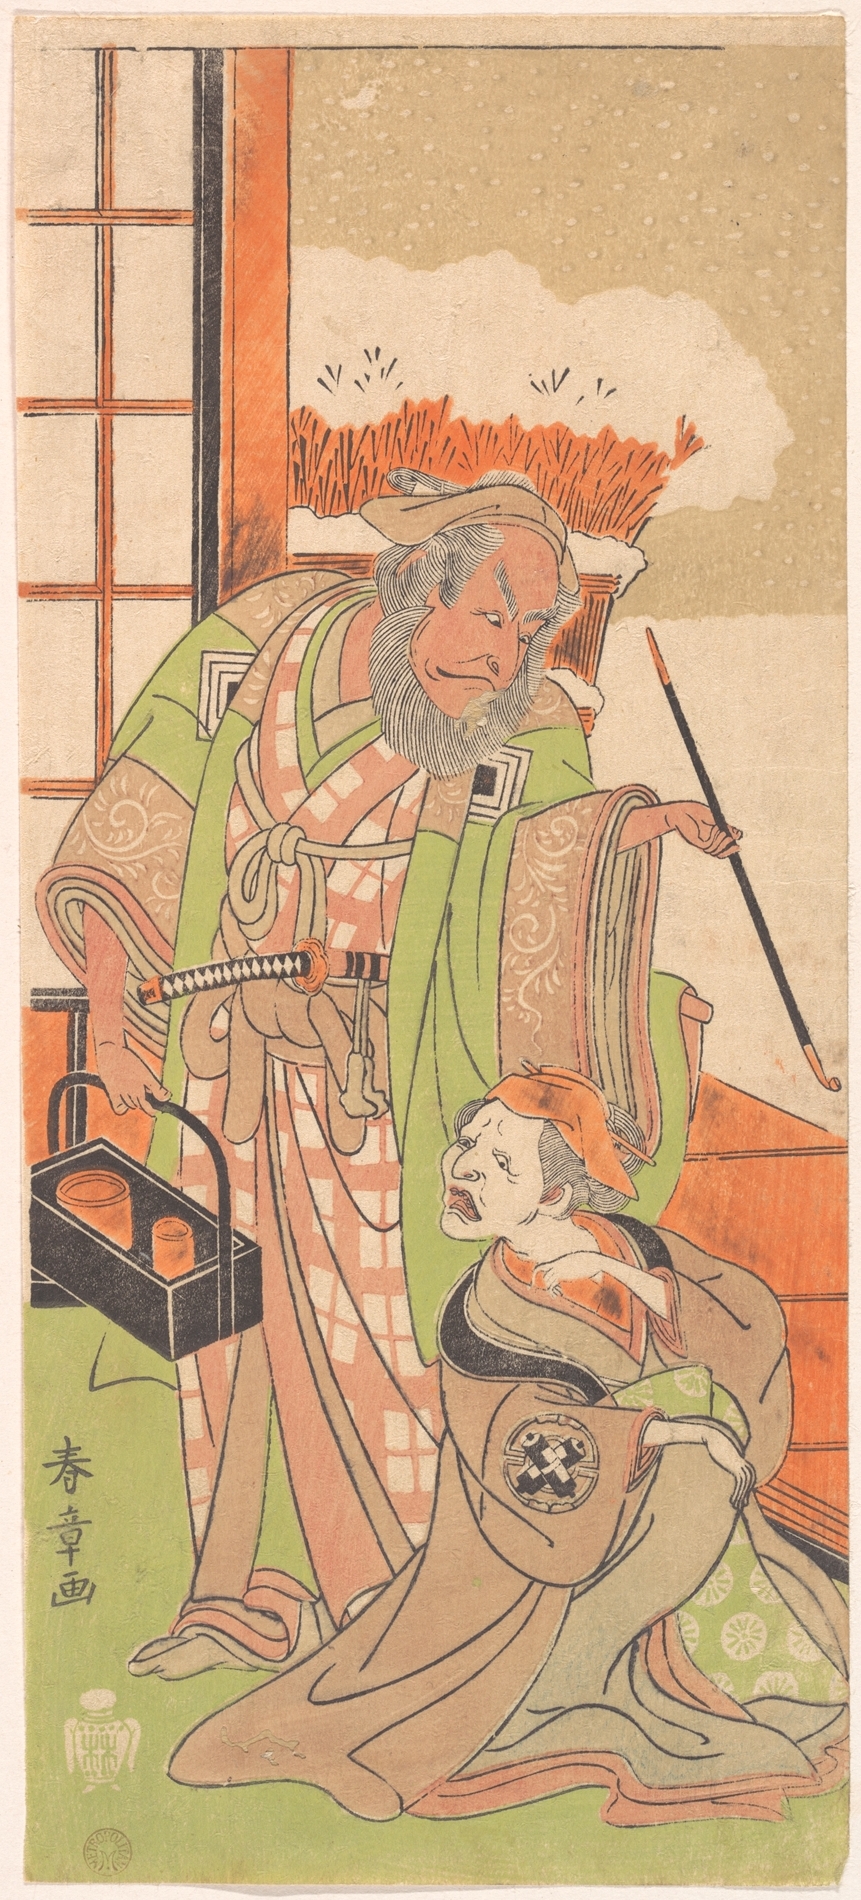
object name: woodblock print nishiki e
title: Scene From the Second Act of the Drama "Kawaranu Hana Sakae Hachinoki"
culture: japanese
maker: katsukawa shunshō 勝川春章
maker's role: artist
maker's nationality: japanese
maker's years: 1726-1792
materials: ink, paper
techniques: nishiki e, woodblock print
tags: men,actors